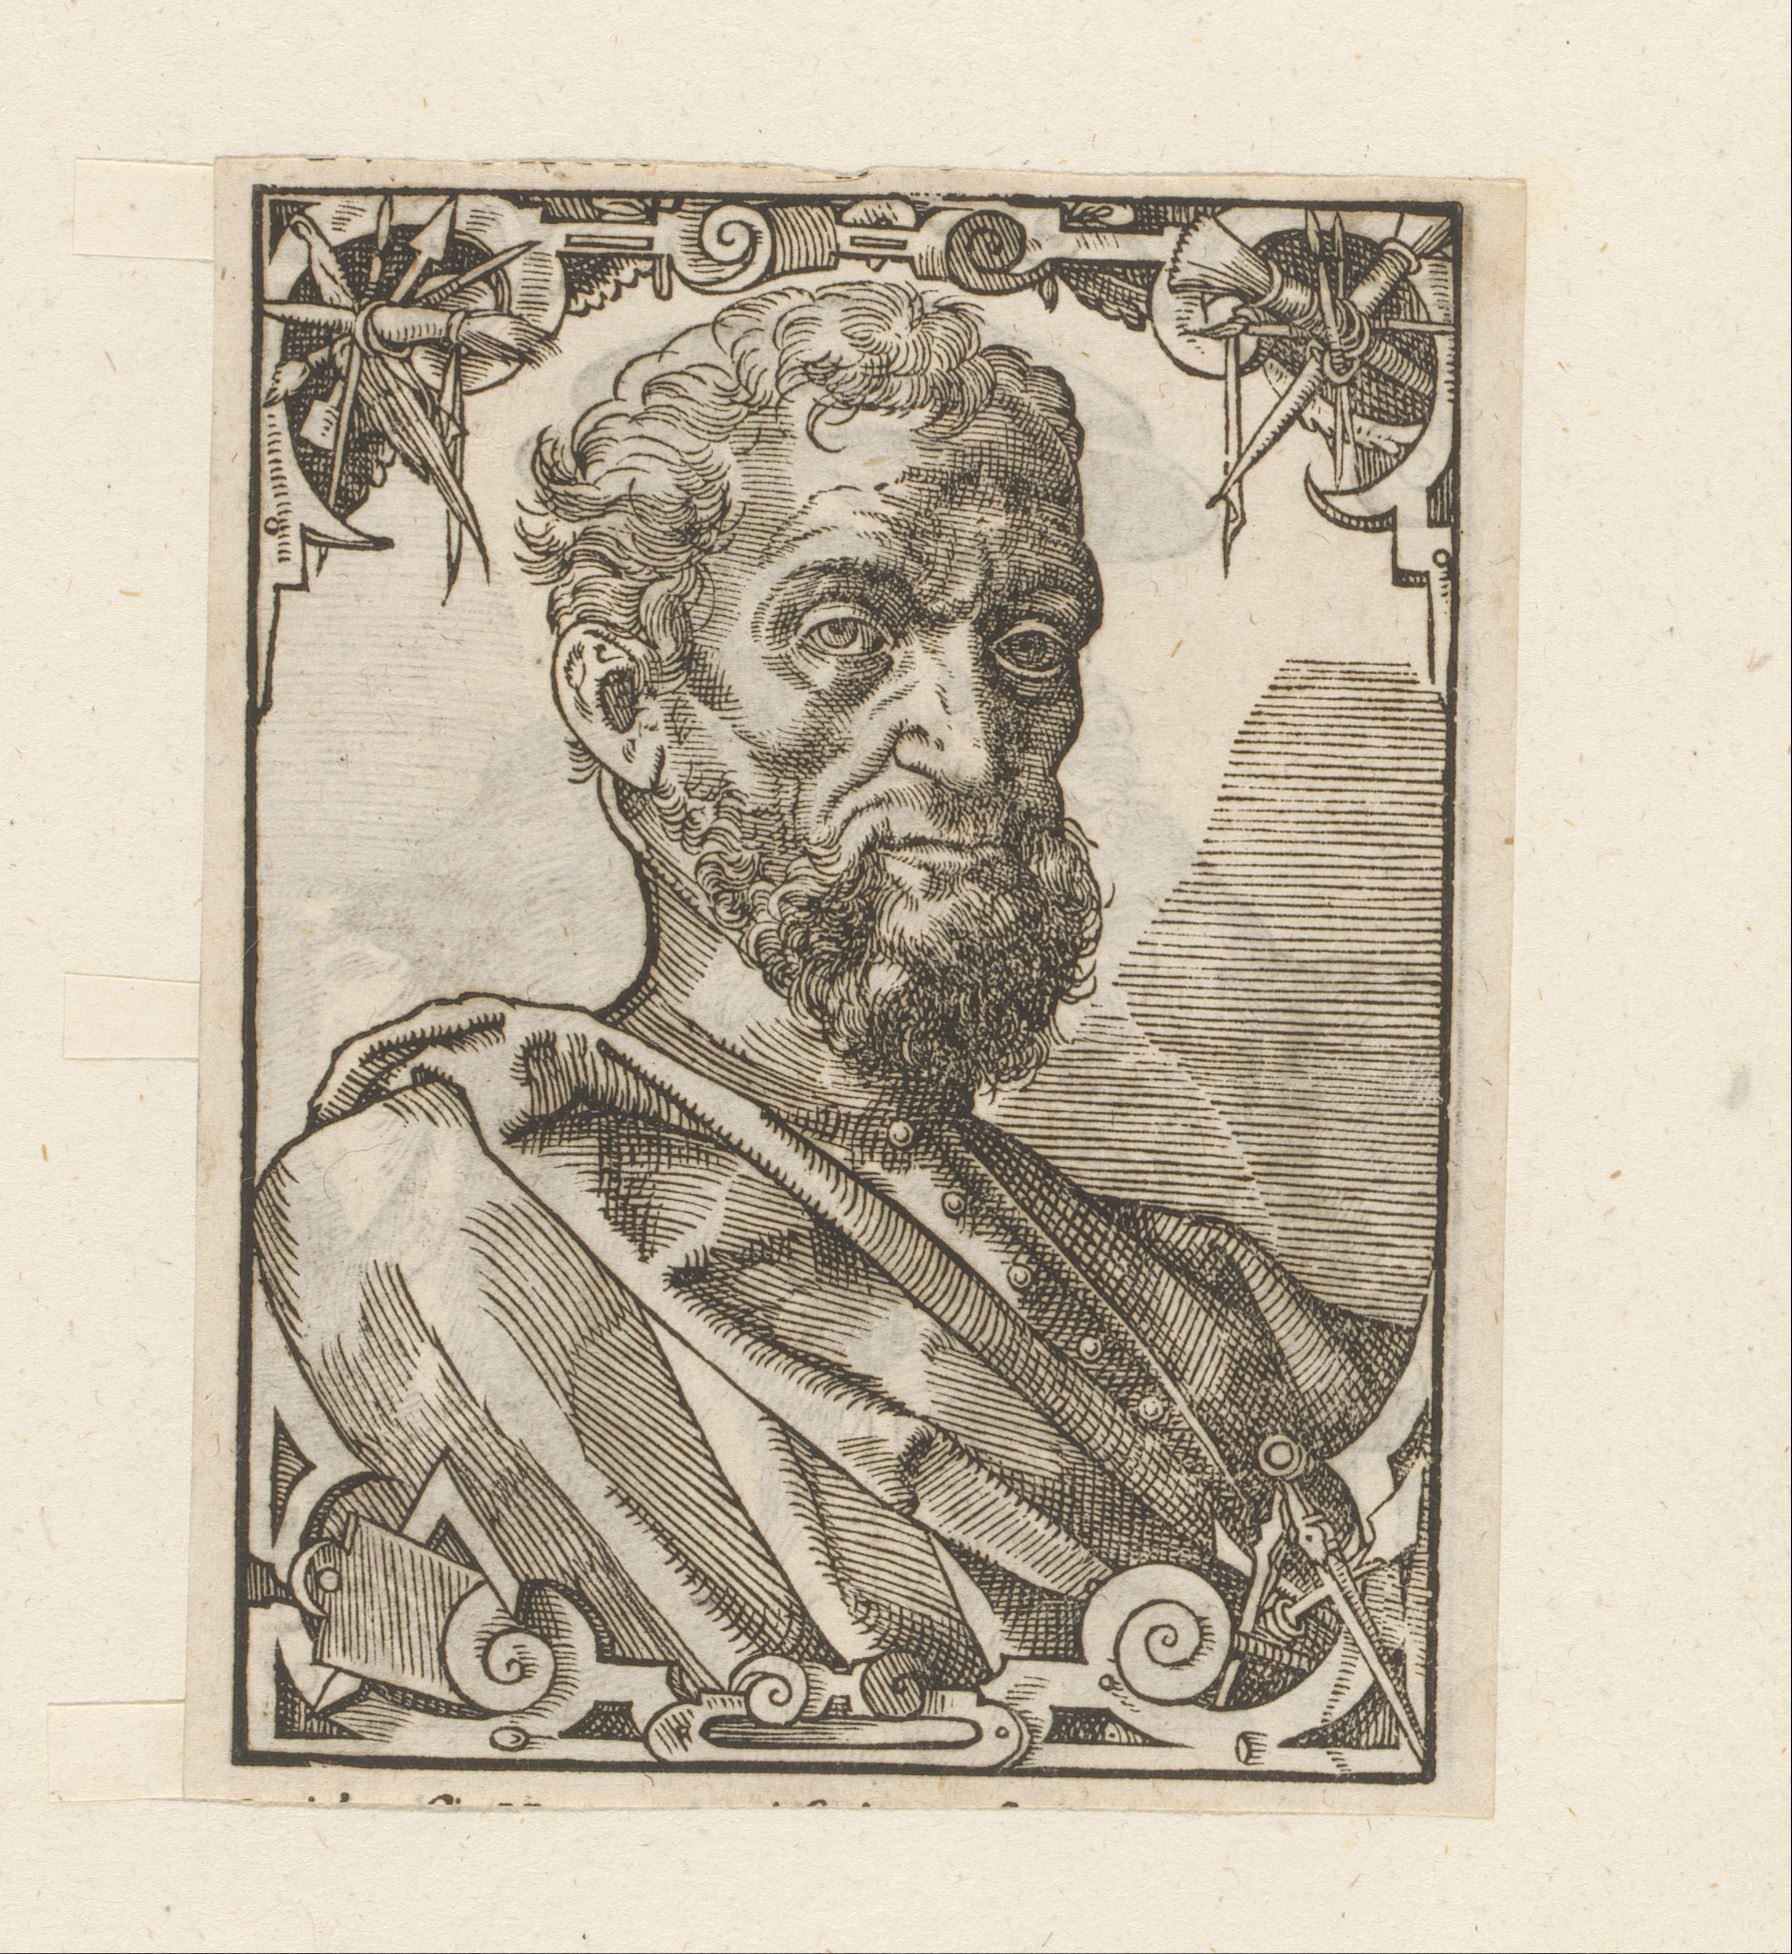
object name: book illustration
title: Portret van Michelangelo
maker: Anonymous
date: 1549-1584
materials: paper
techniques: woodcut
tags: rome, painter, draughtsman, sculptor, michelangelo, historical persons, portrait, self-portrait of painter, portrait, self-portrait of graphic artist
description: Prent gebruikt in: Reusner, Nikolaus. Icones Sive Imagines Vivae. Bazel: Conrad Waldkirch, 1589.